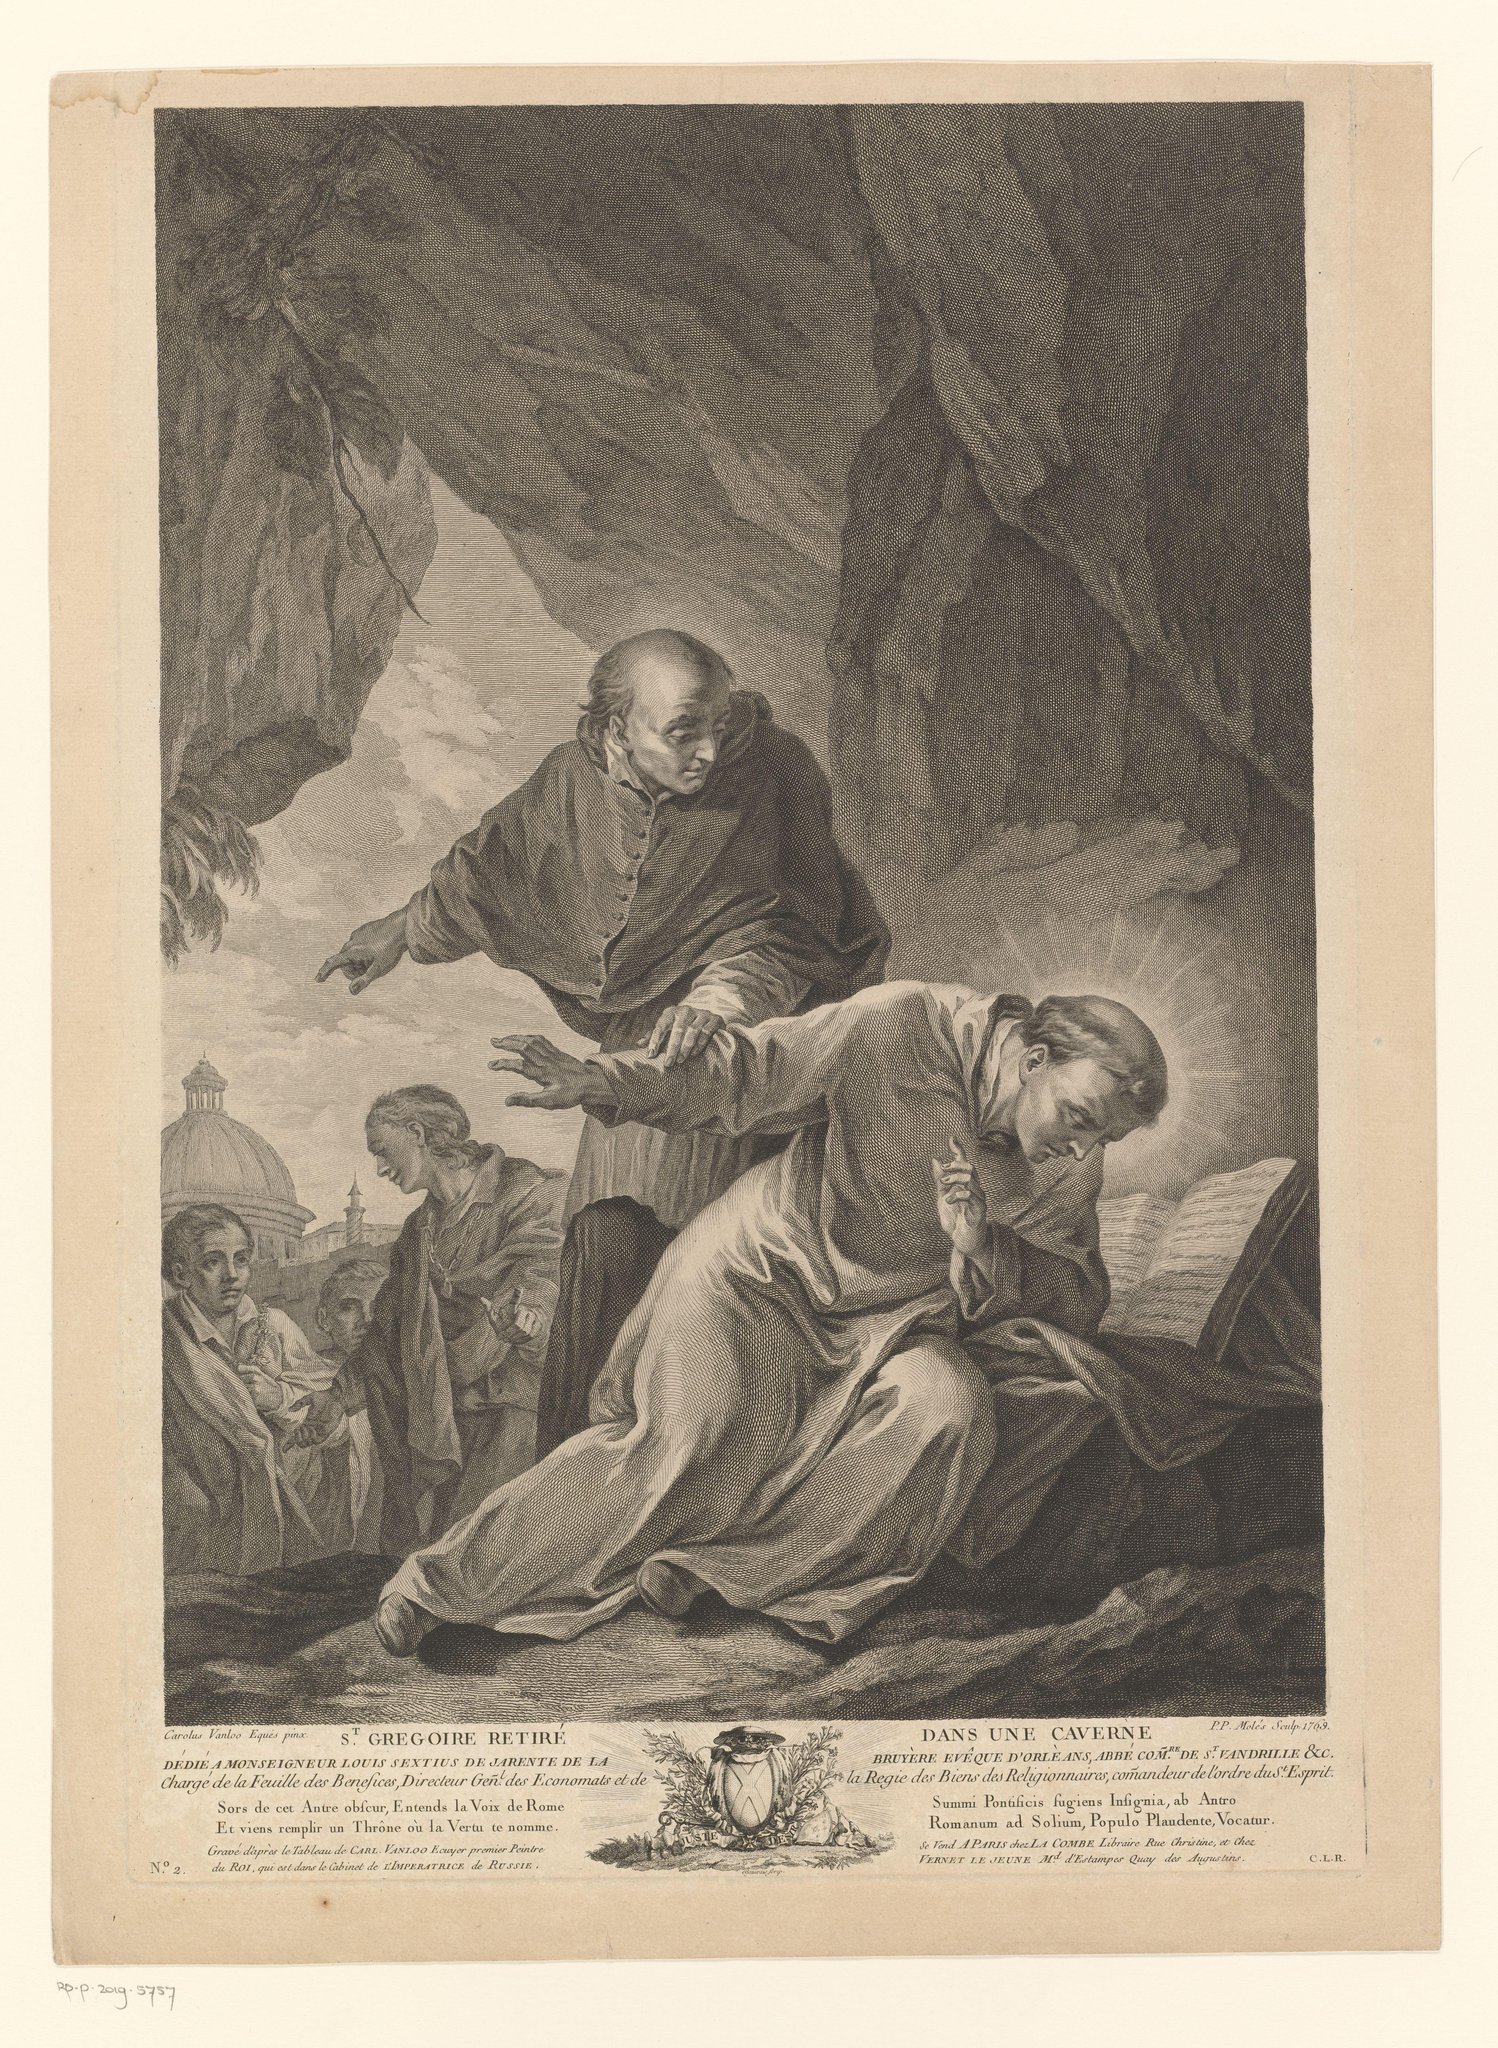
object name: print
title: H. Gregorius trekt zich terug in een grot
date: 1769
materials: paper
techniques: engraving, etching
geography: paris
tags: cave, grotto, pope gregory the great; possible attributes: dove, emperor trajan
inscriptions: collector's mark: Lugt 2228